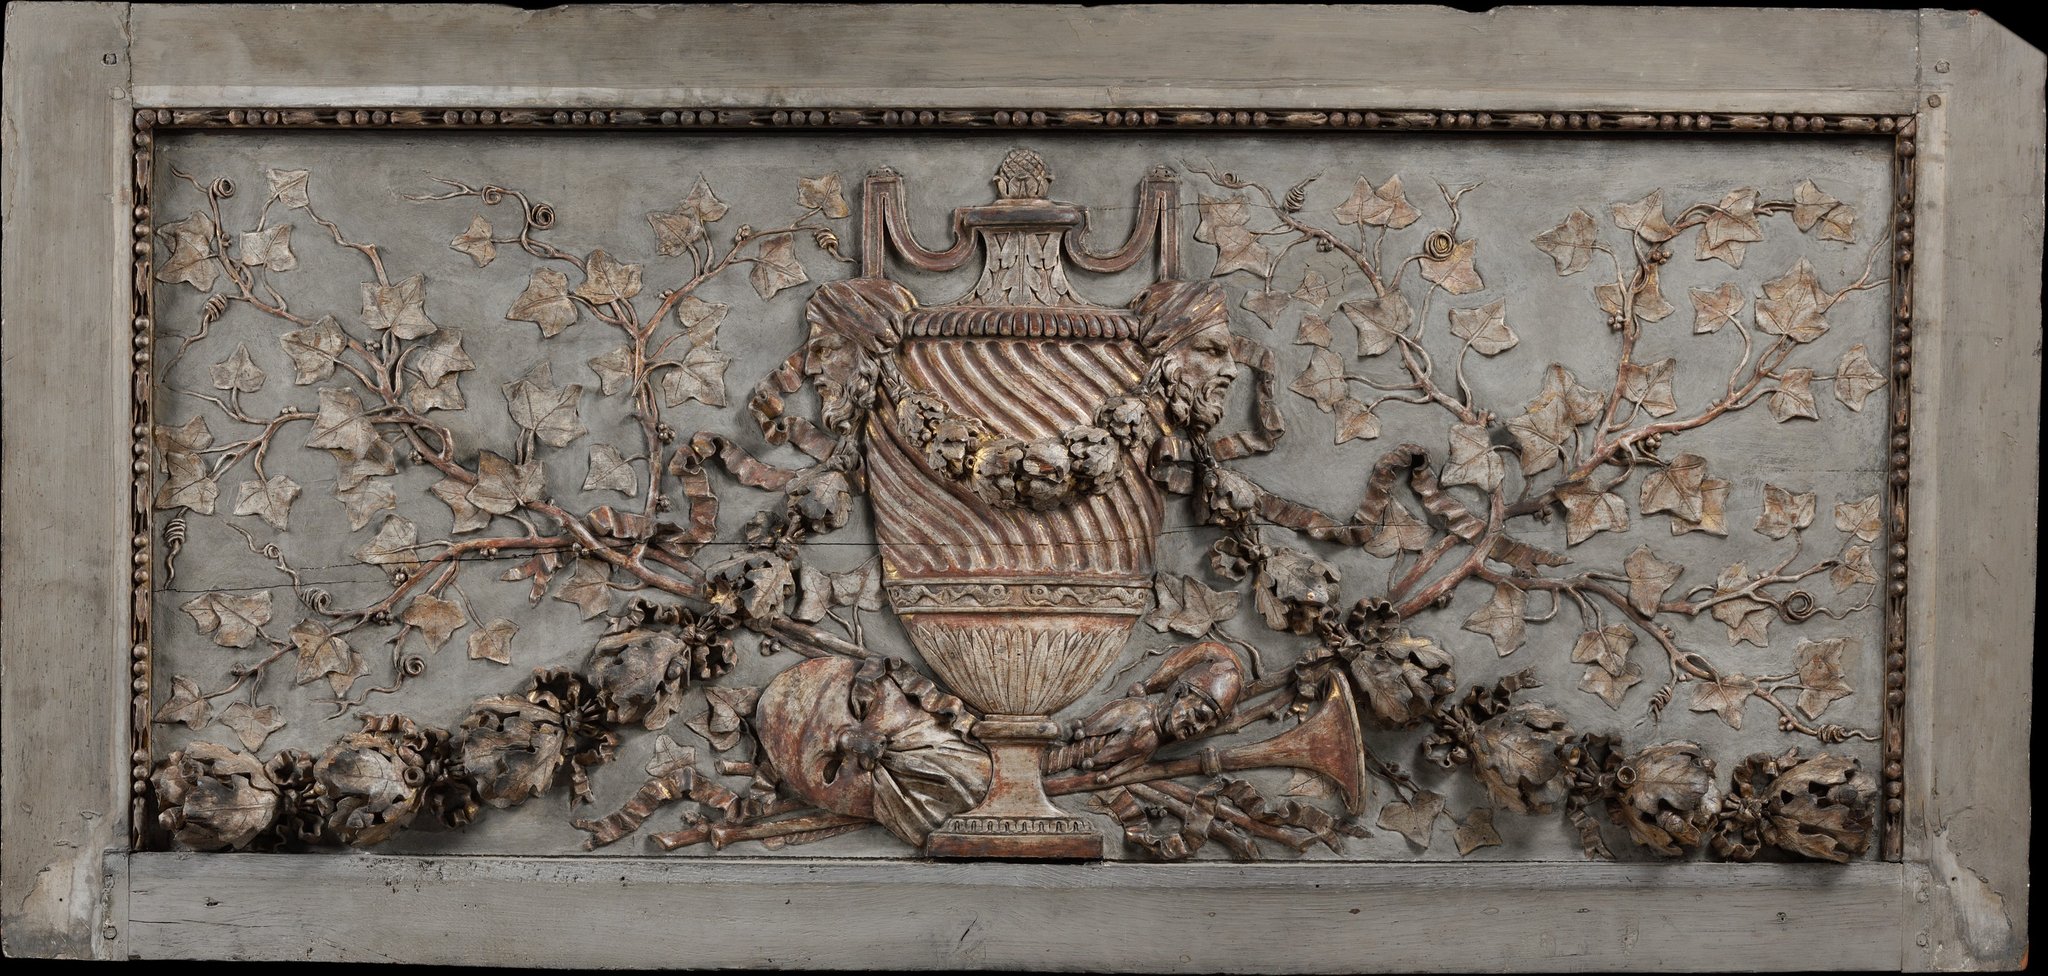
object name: panel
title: Panels depicting the Four Seasons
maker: françois joseph belanger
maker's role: maker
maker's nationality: french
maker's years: 1744-1818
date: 1775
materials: gilt, wood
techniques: carving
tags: garlands,faces,men,leaves,trophies